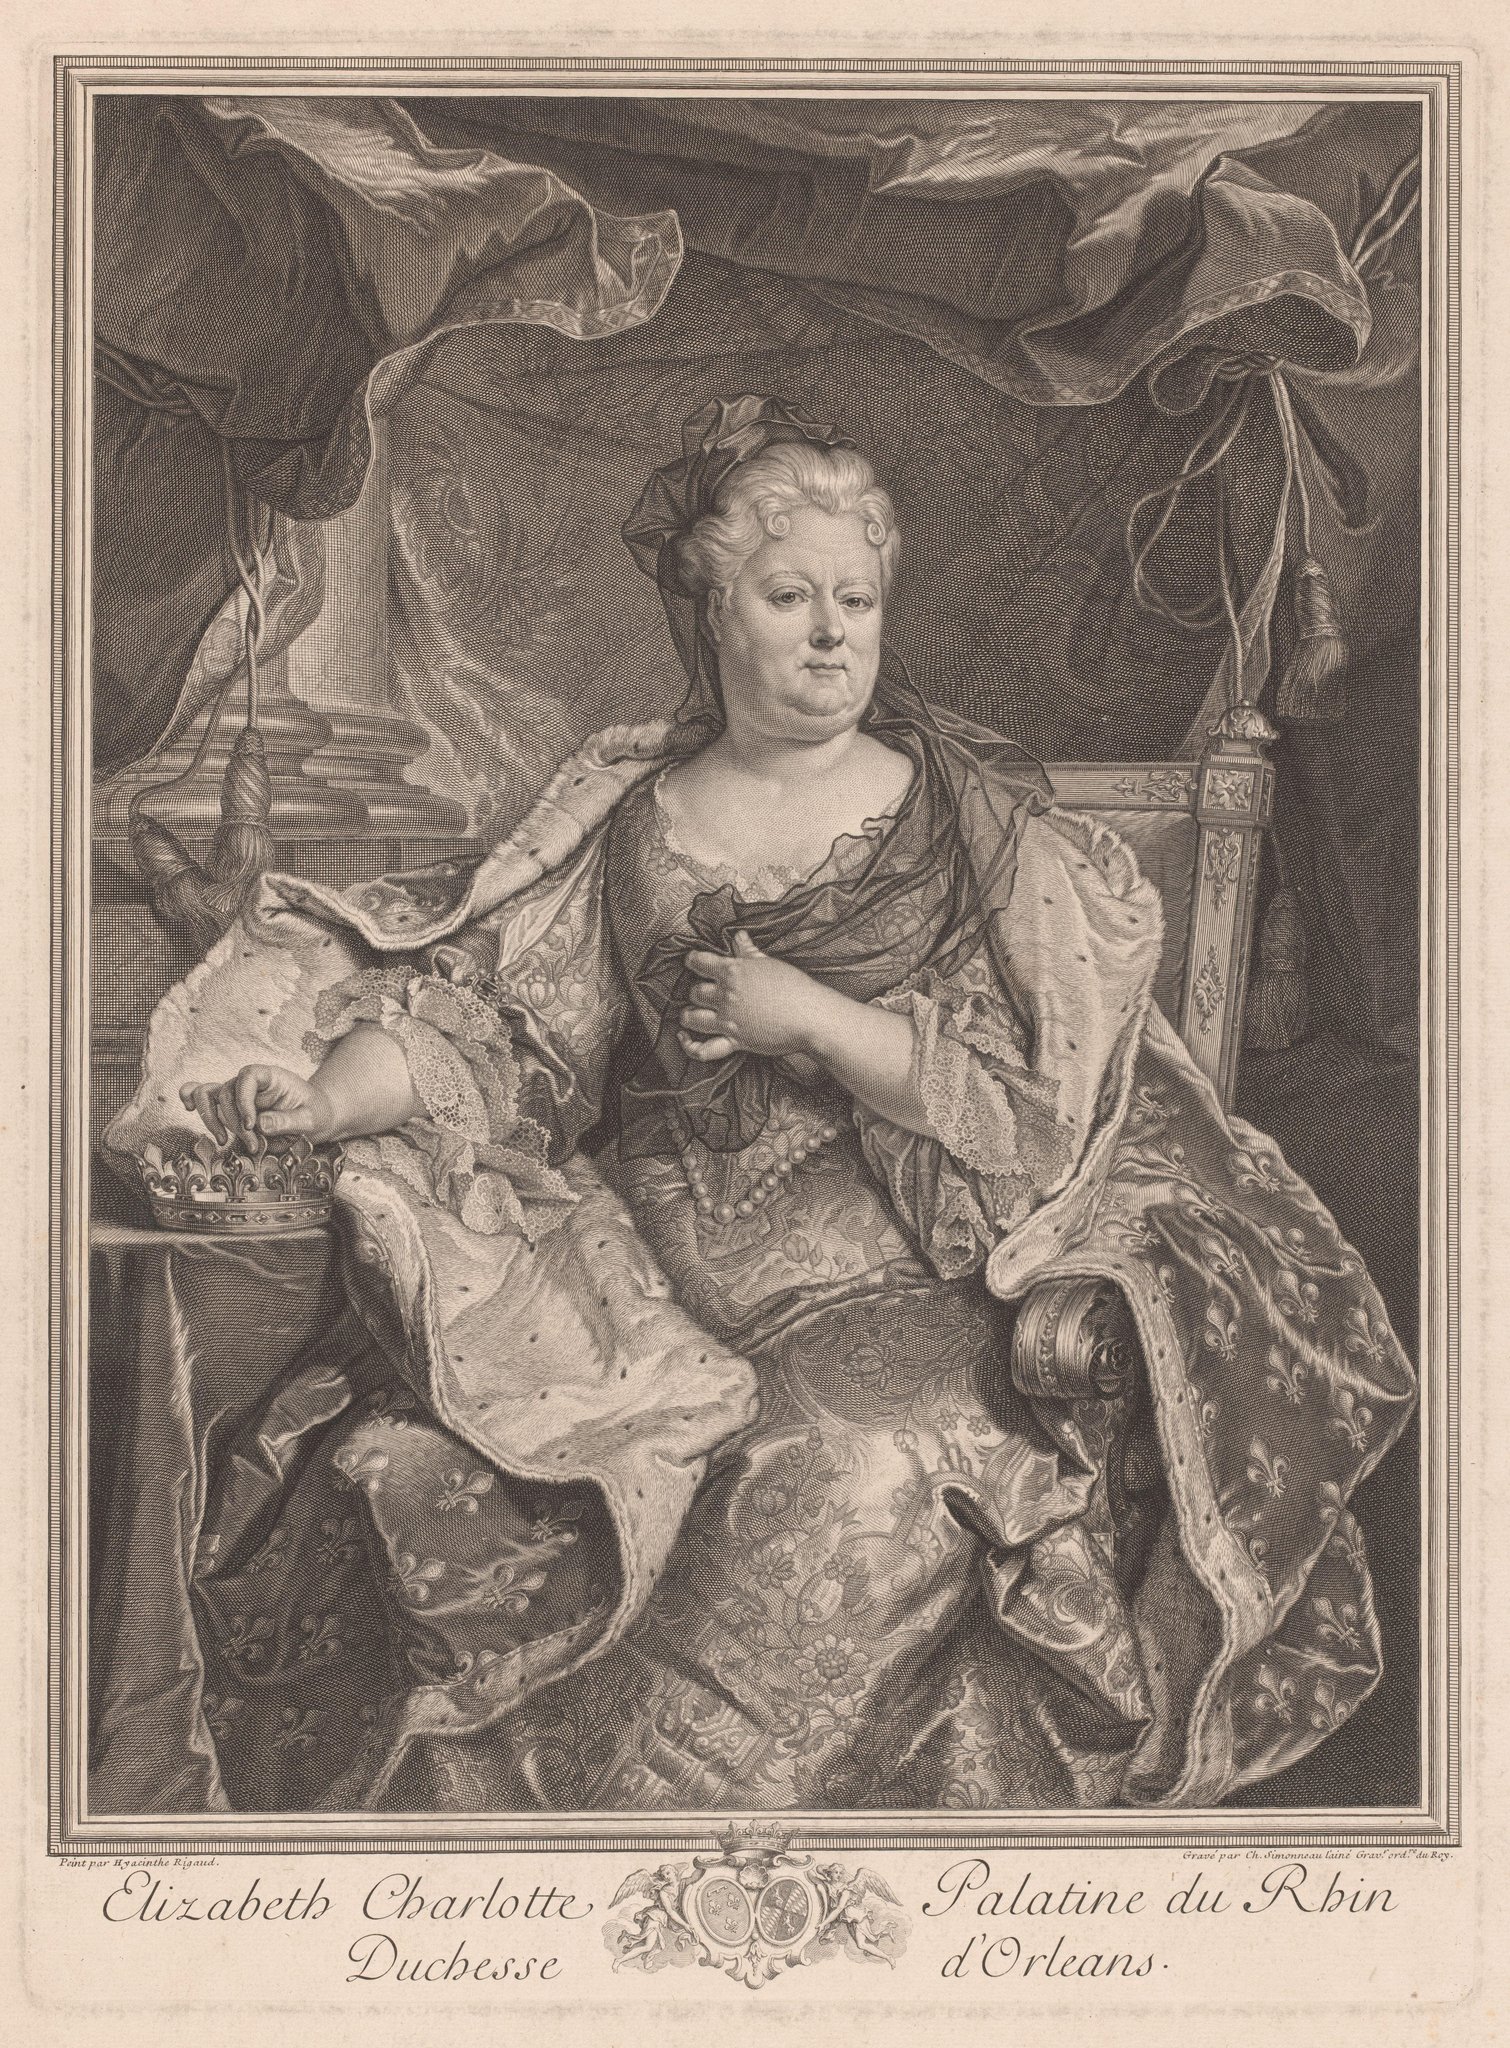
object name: print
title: Portret van Elisabeth Charlotte van Orléans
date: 1655-1728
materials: paper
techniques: engraving, etching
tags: historical persons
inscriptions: collector's mark: Lugt 240